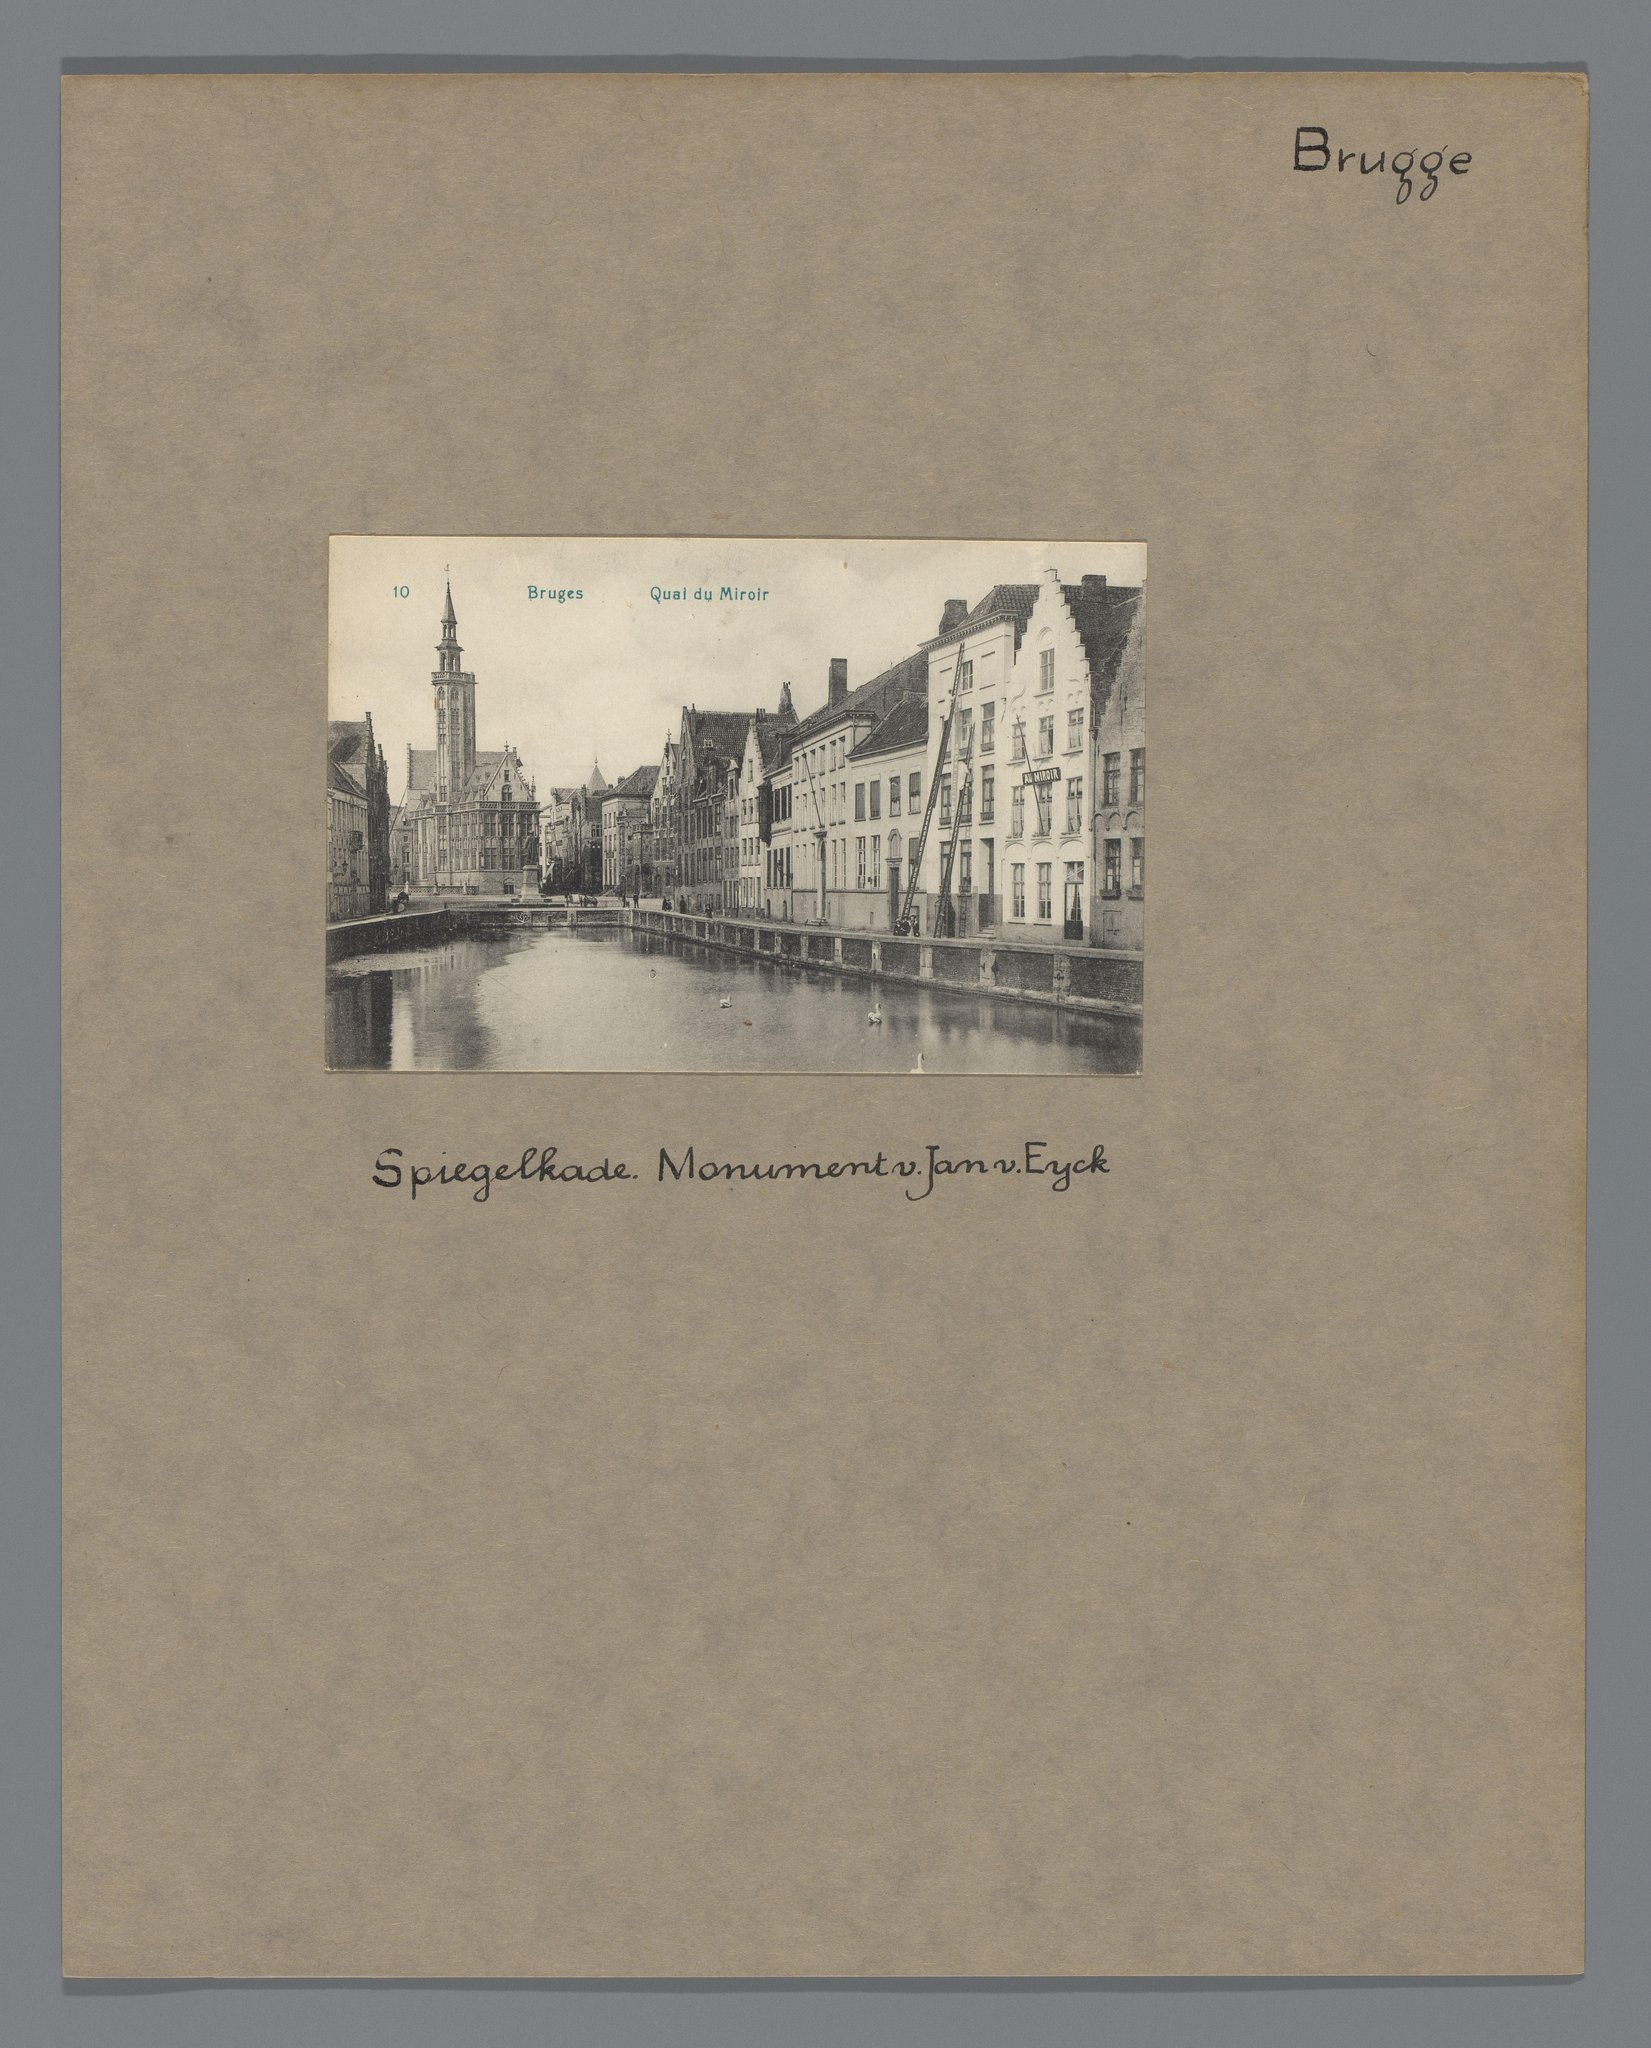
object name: photograph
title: Brugge. Spiegelkade. Monument Jan van Eyck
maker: Anonymous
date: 1860-1925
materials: photographic support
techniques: photograph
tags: bruges, draughtsman, jan van eyck